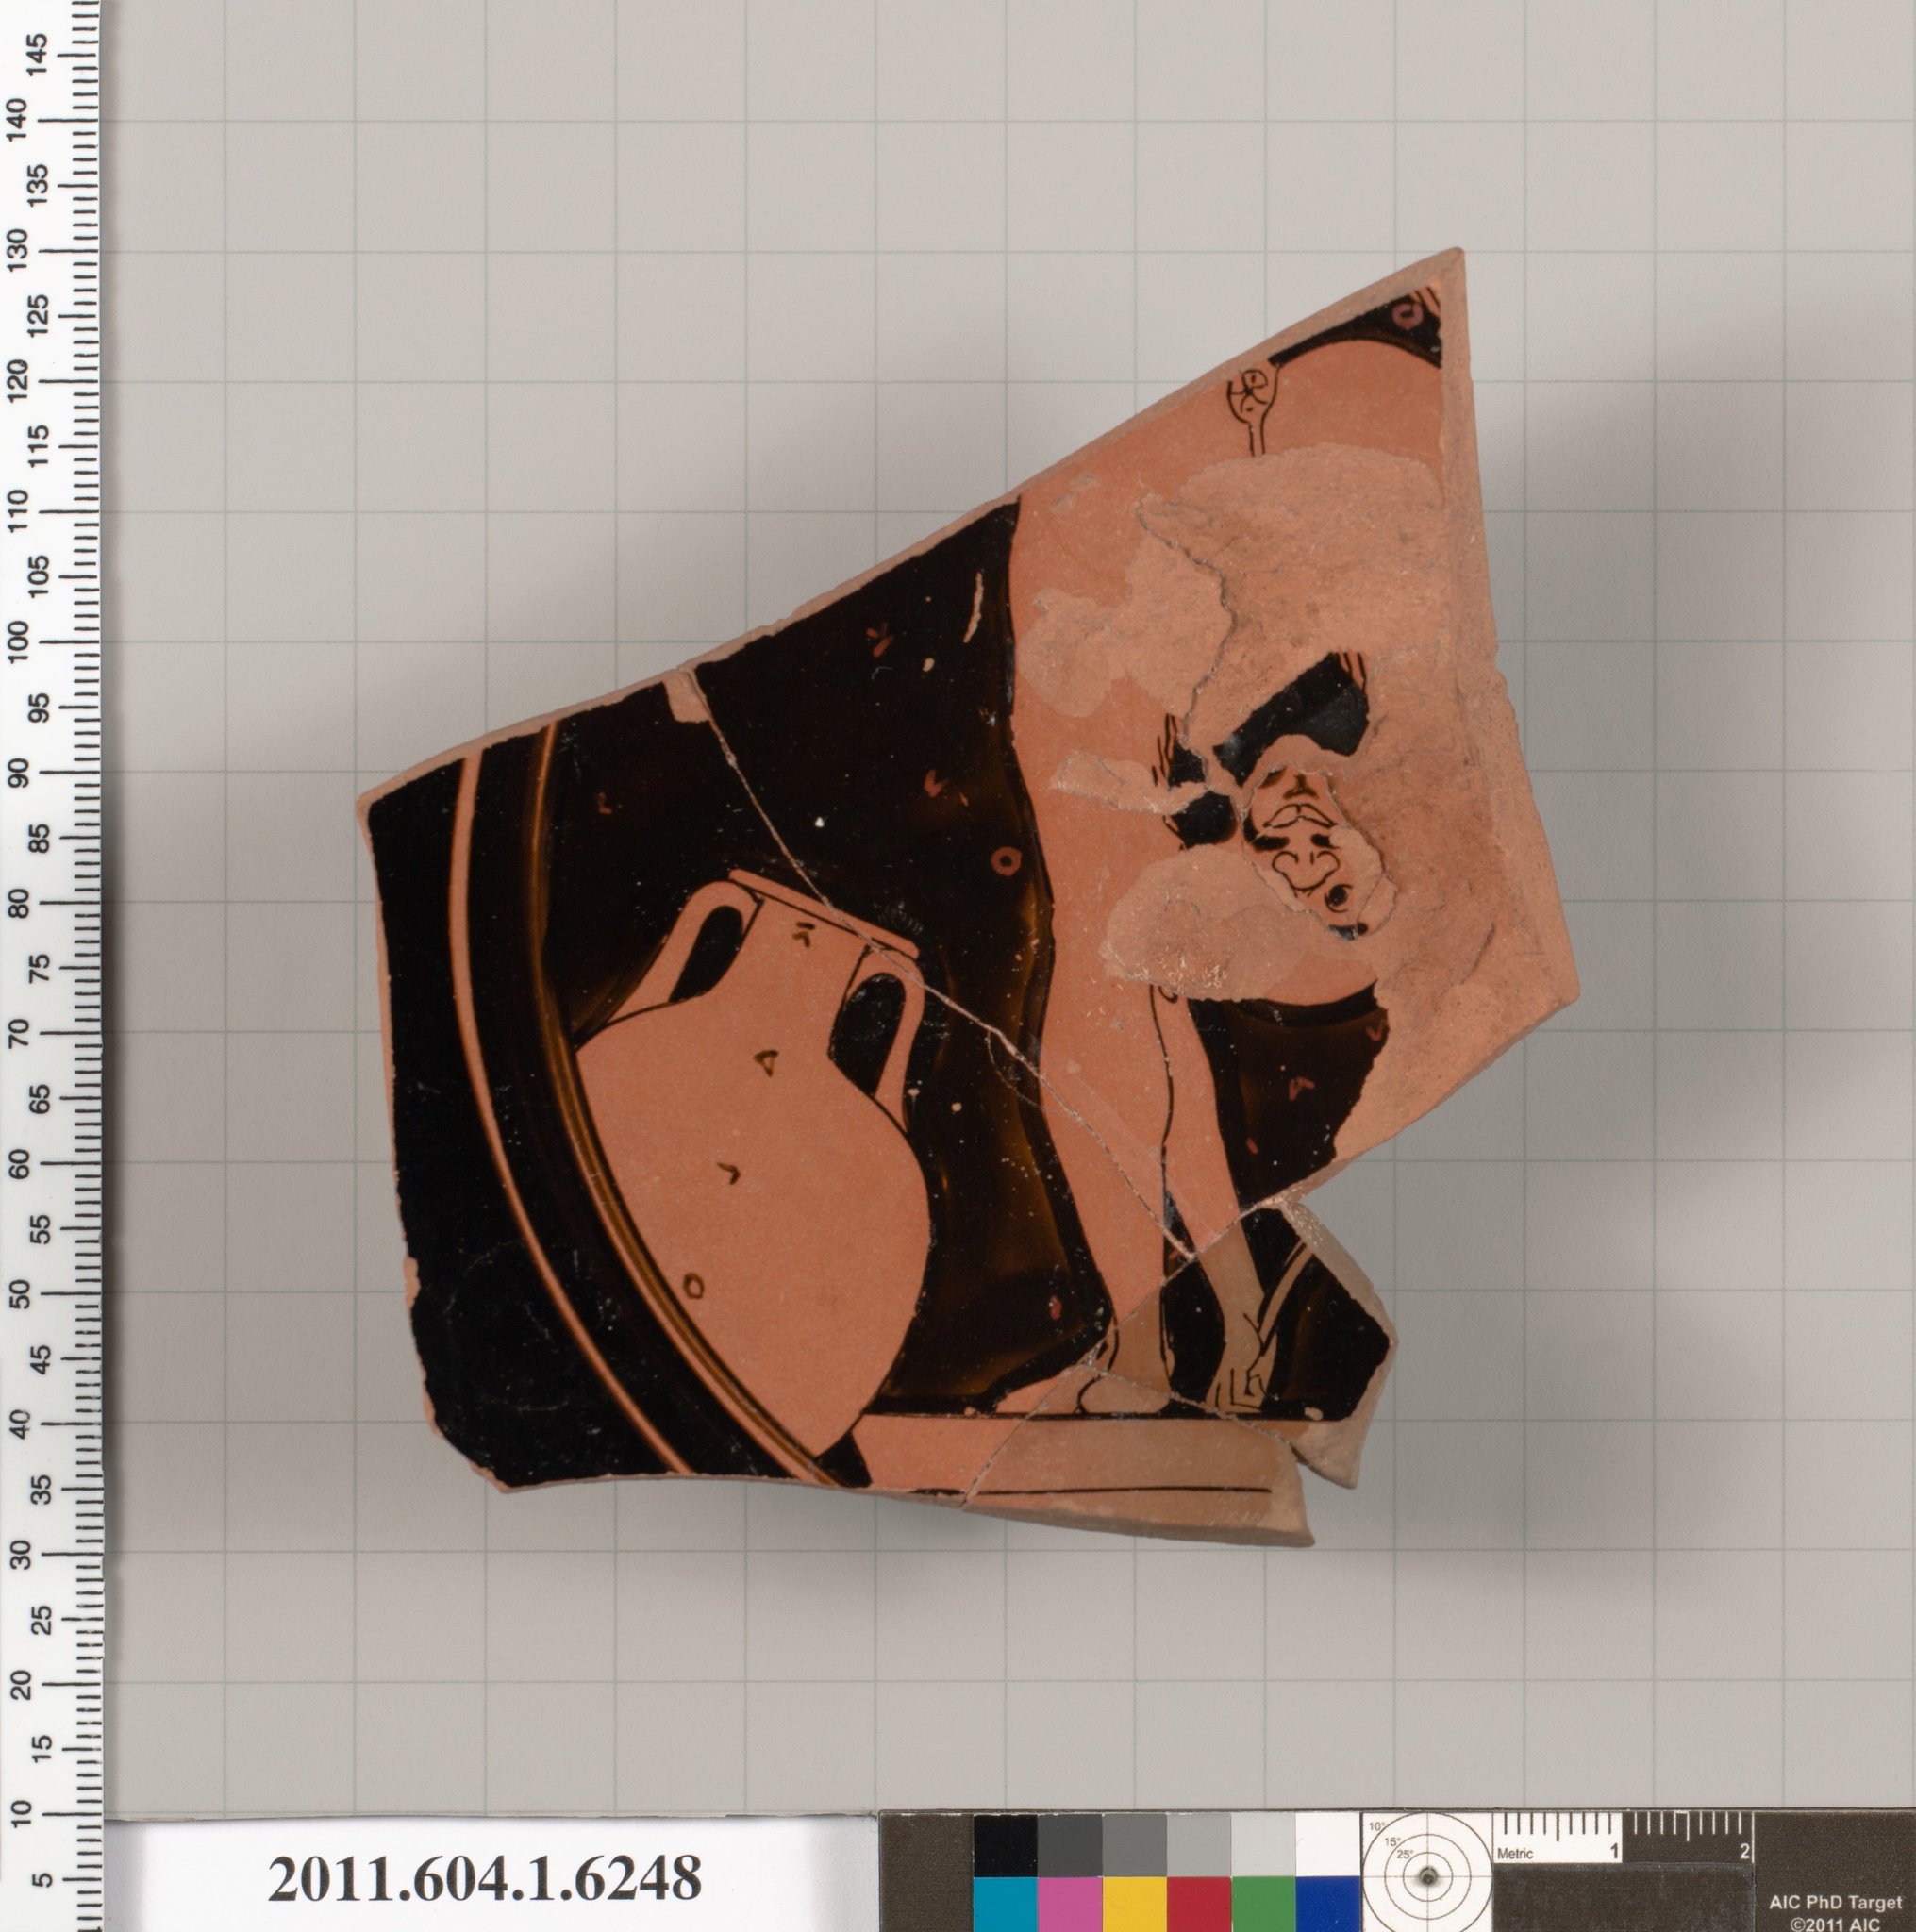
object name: kylix fragment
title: Terracotta fragment of a kylix (drinking cup)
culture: greek, attic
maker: onesimos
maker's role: artist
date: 500-480 BCE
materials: terracotta